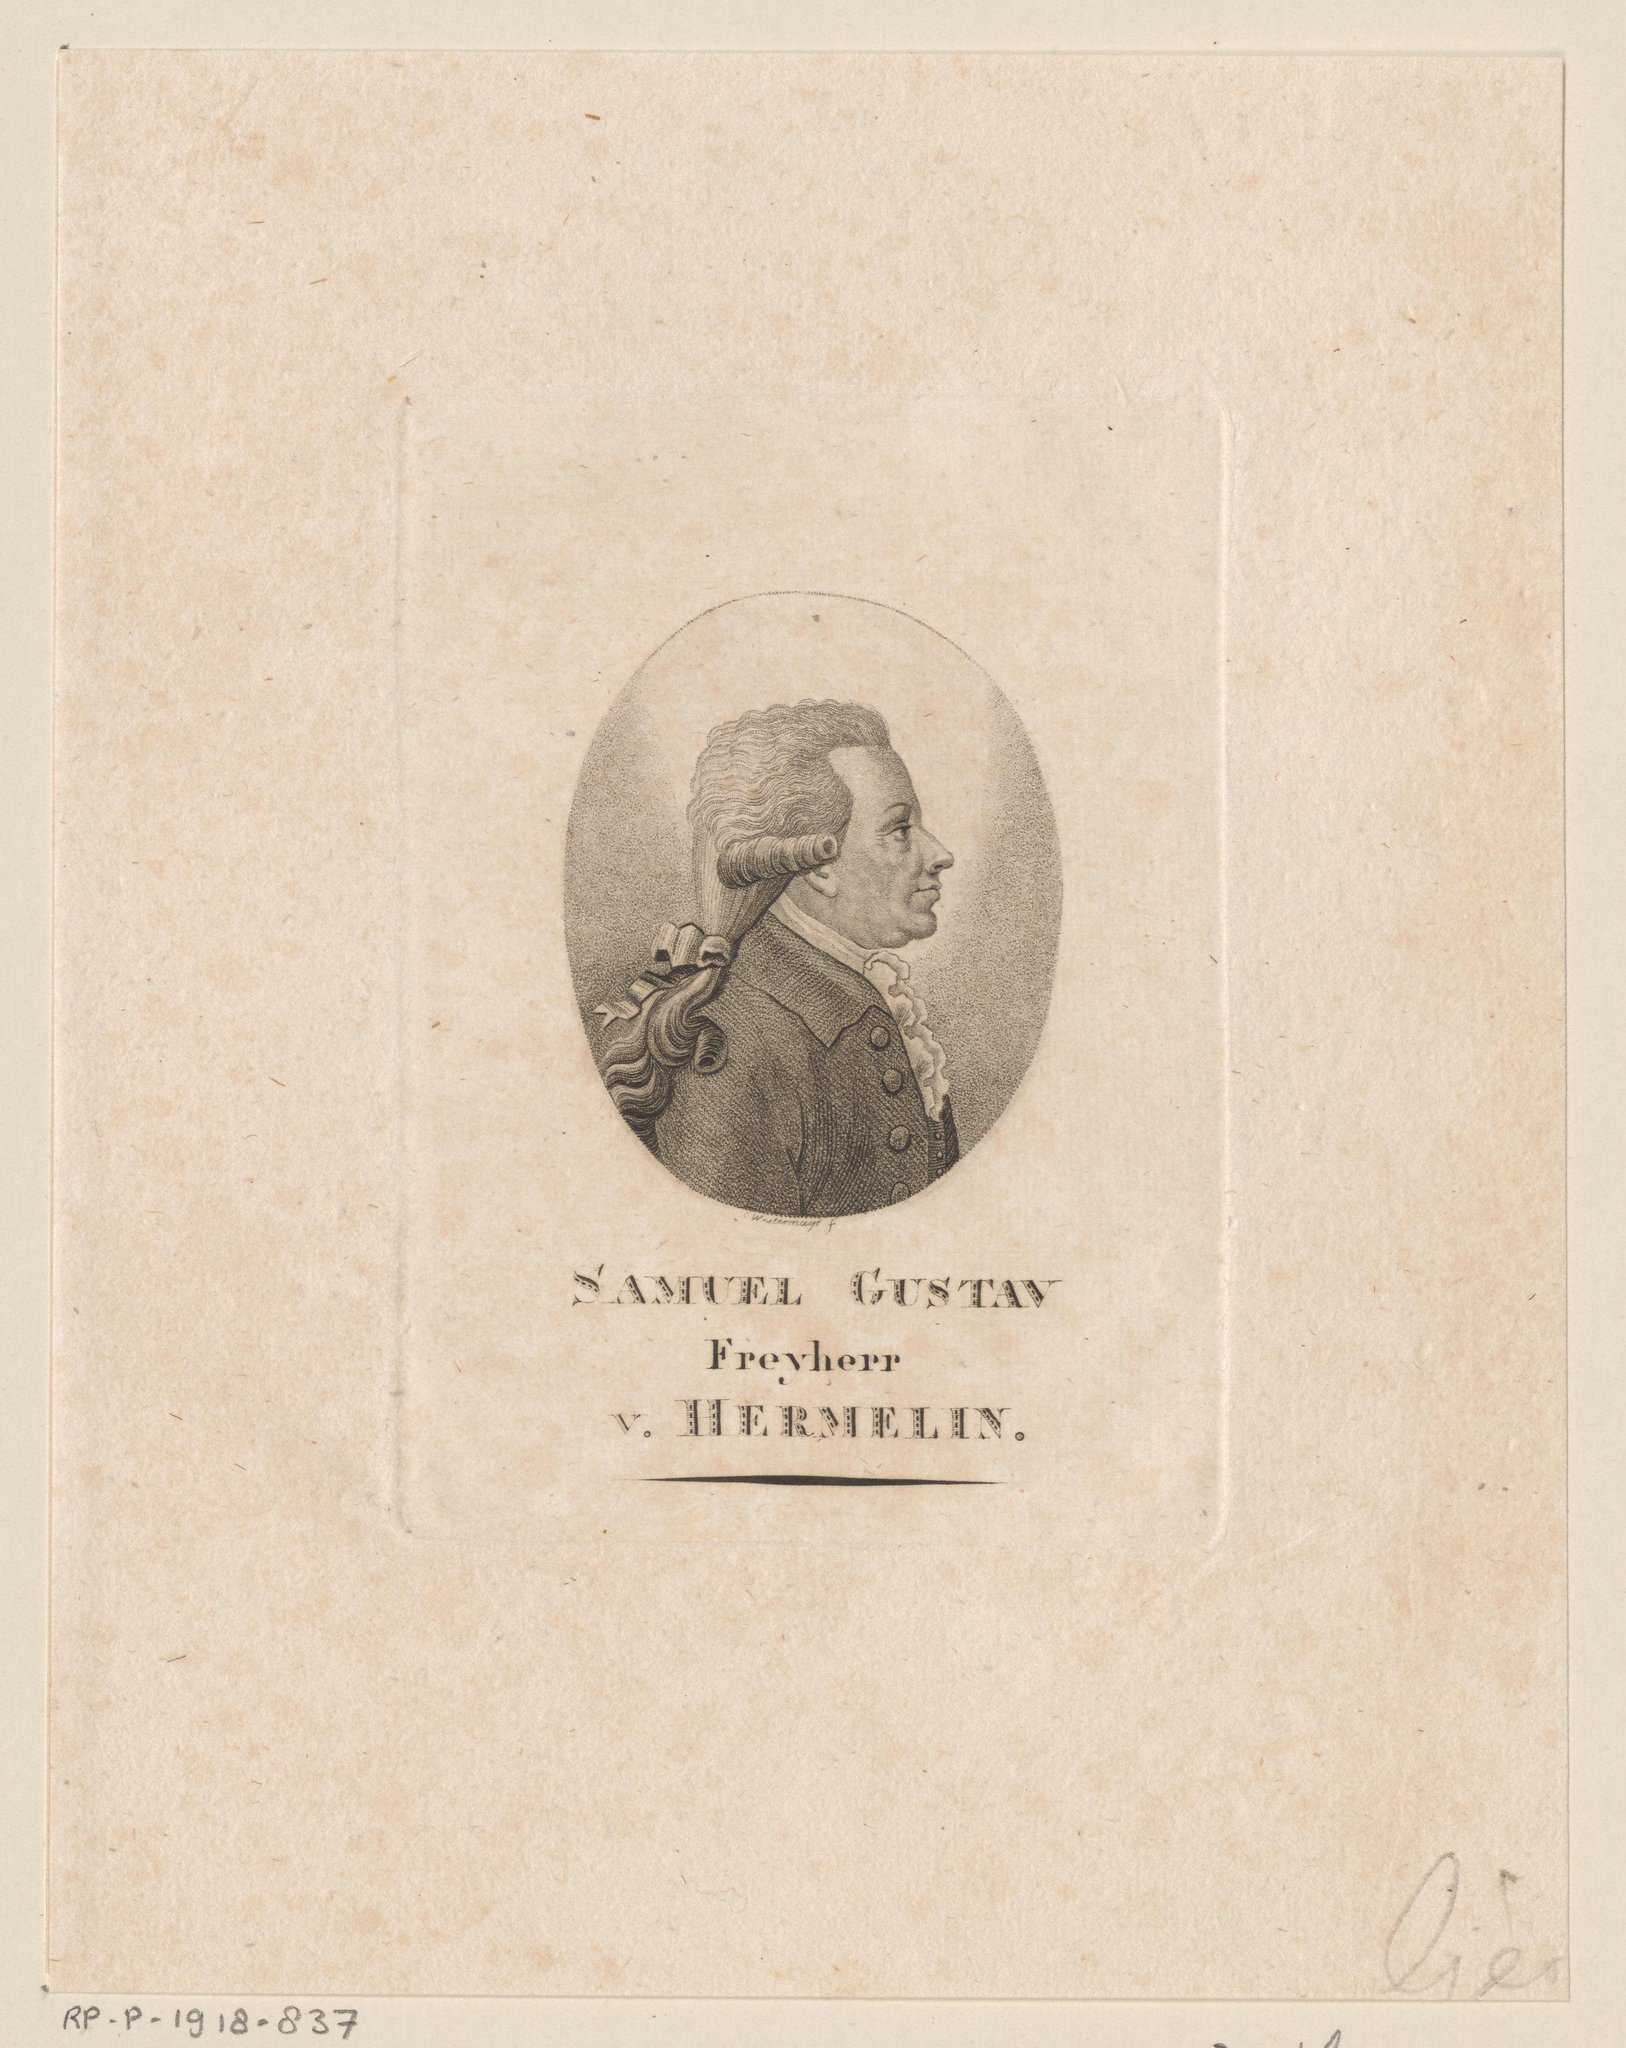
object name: print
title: Portret van Samuel Gustaf von Hermelin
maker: konrad westermayr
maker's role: print maker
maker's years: 1765-1834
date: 1775-1834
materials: paper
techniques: etching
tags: historical persons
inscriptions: collector's mark: Lugt 2233